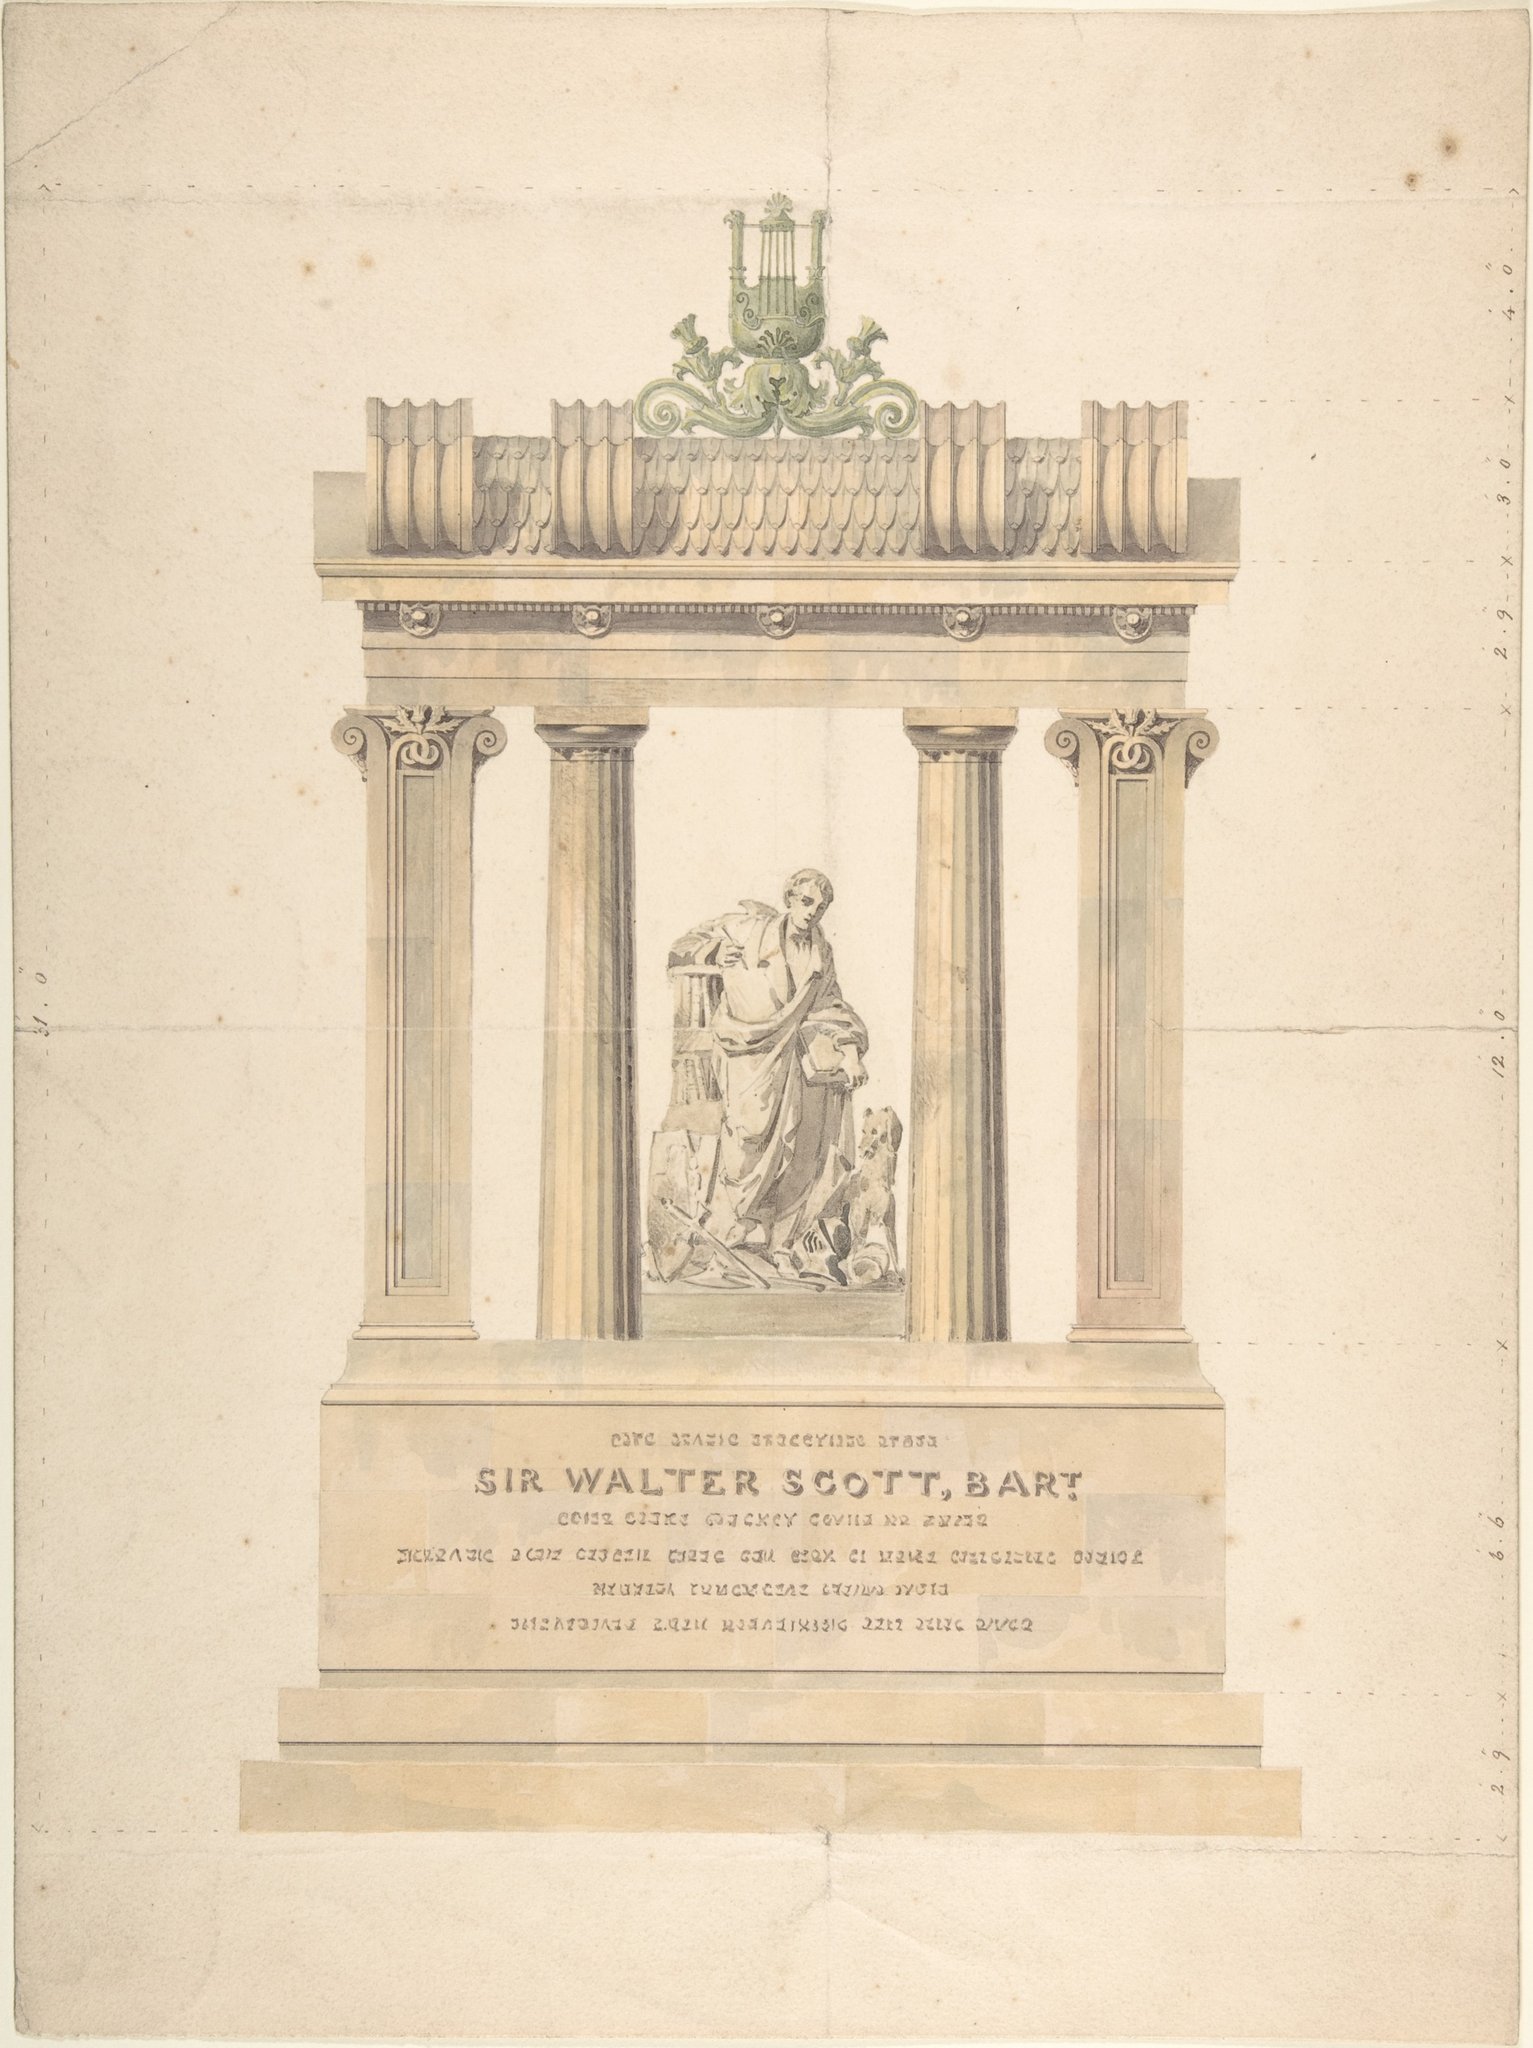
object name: drawing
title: Monument to Sir Walter Scott, Bart.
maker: charles harriott smith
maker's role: artist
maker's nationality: british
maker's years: 1792-1864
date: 1832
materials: graphite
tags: monuments,men